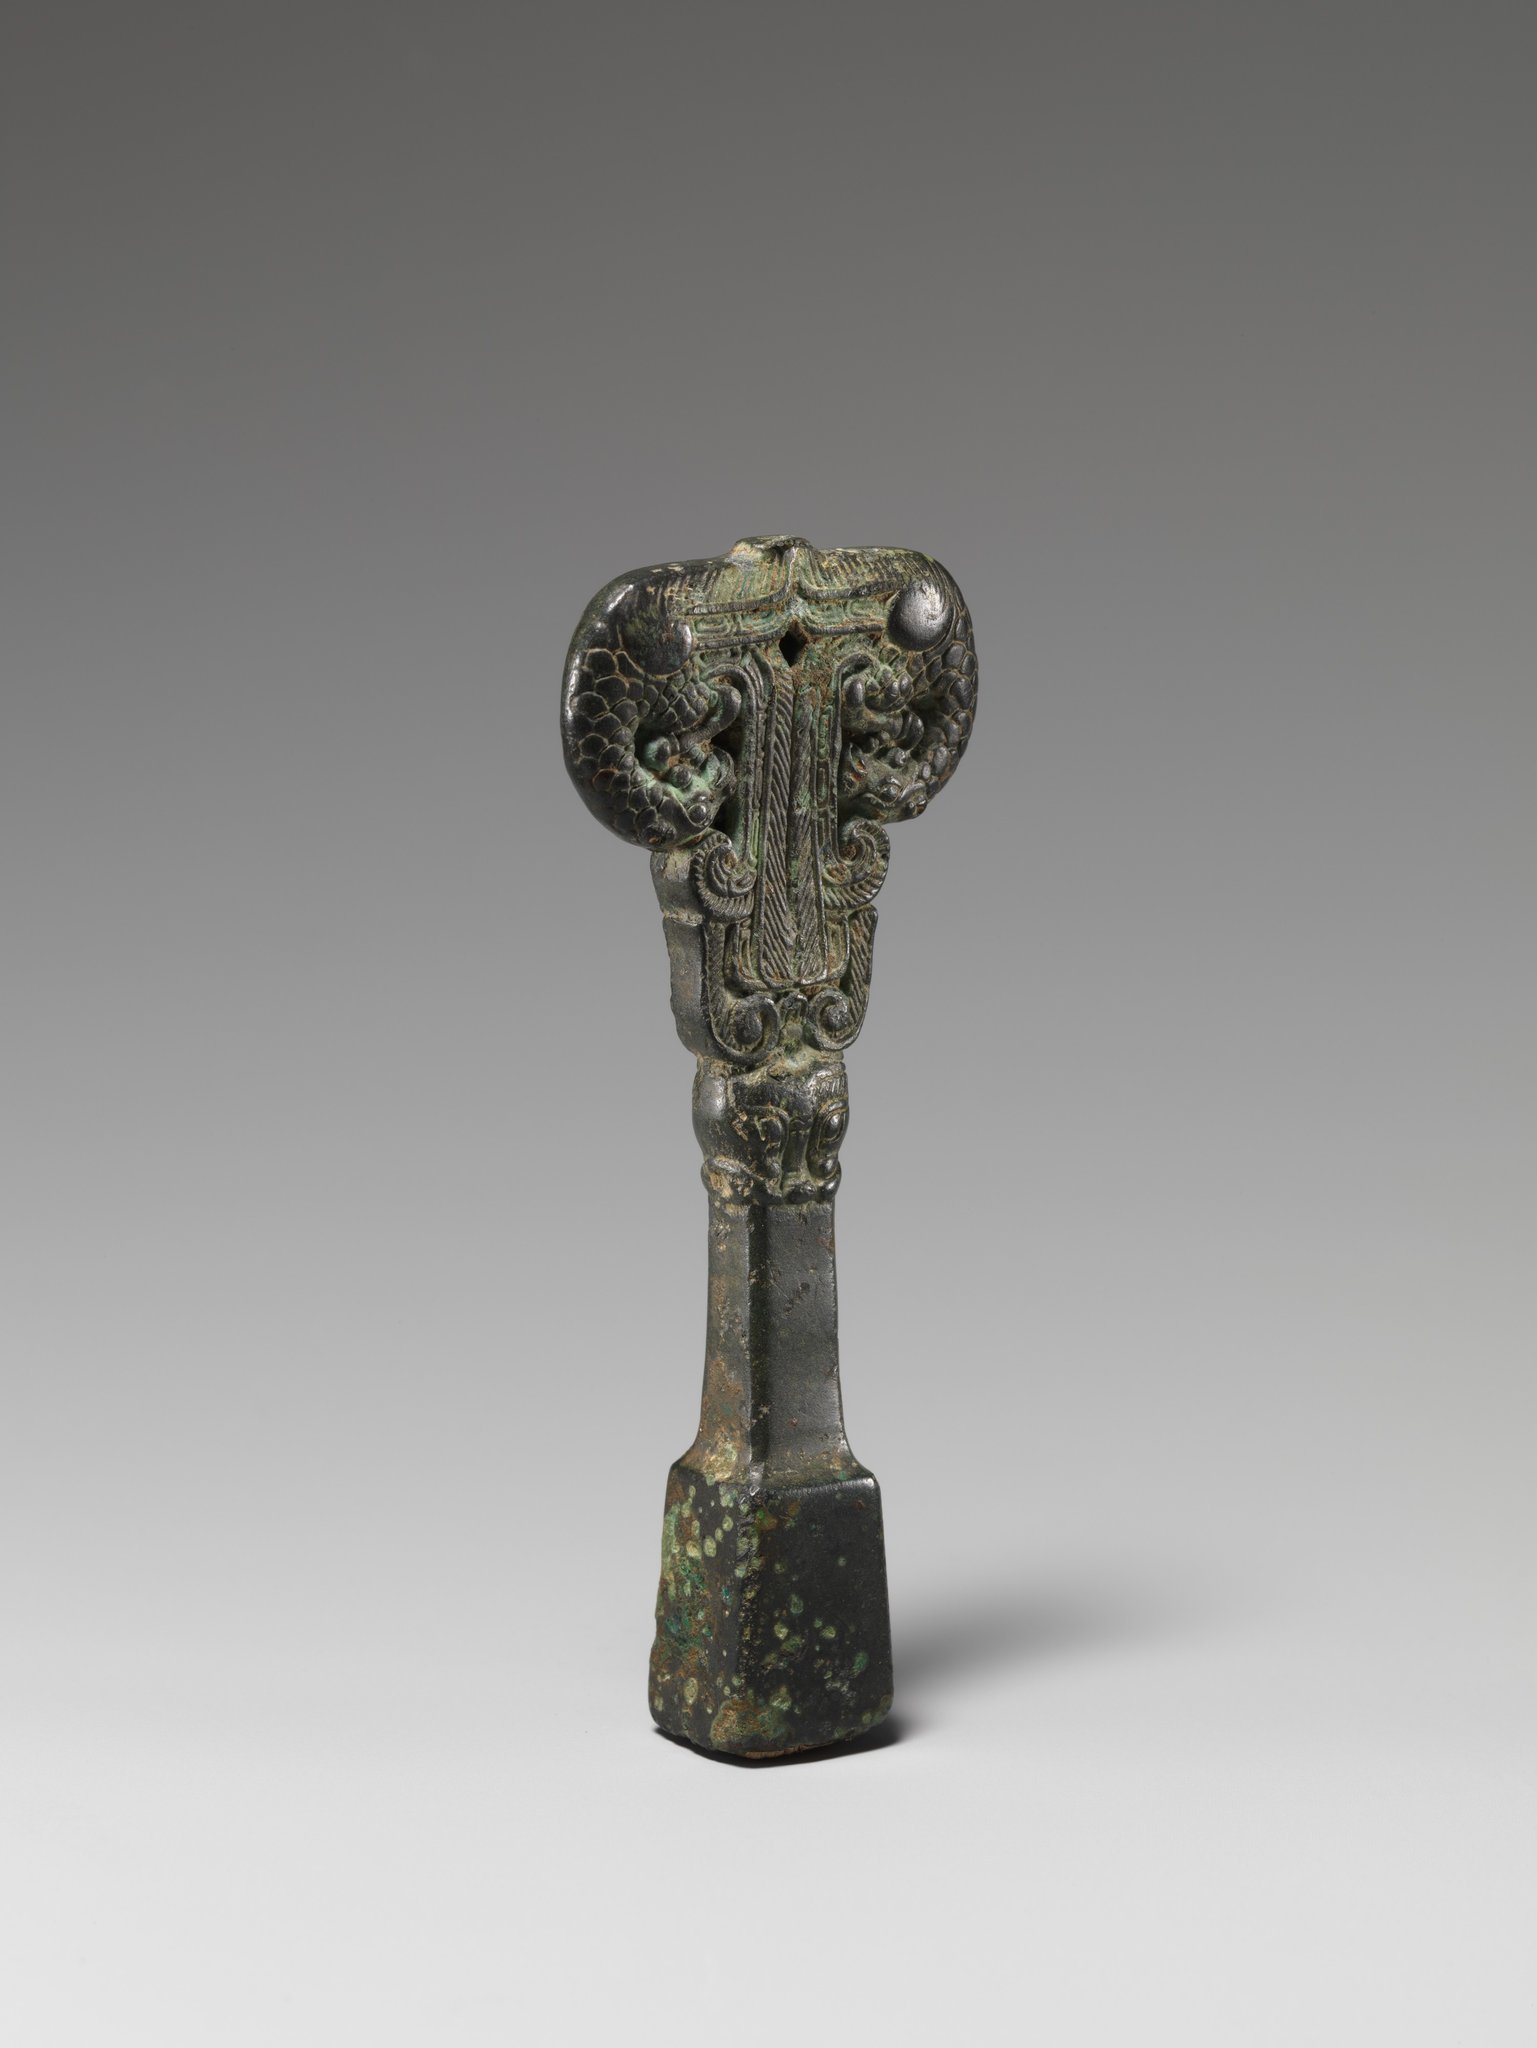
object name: tuning key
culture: chinese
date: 500-201 BCE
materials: bronze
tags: fish